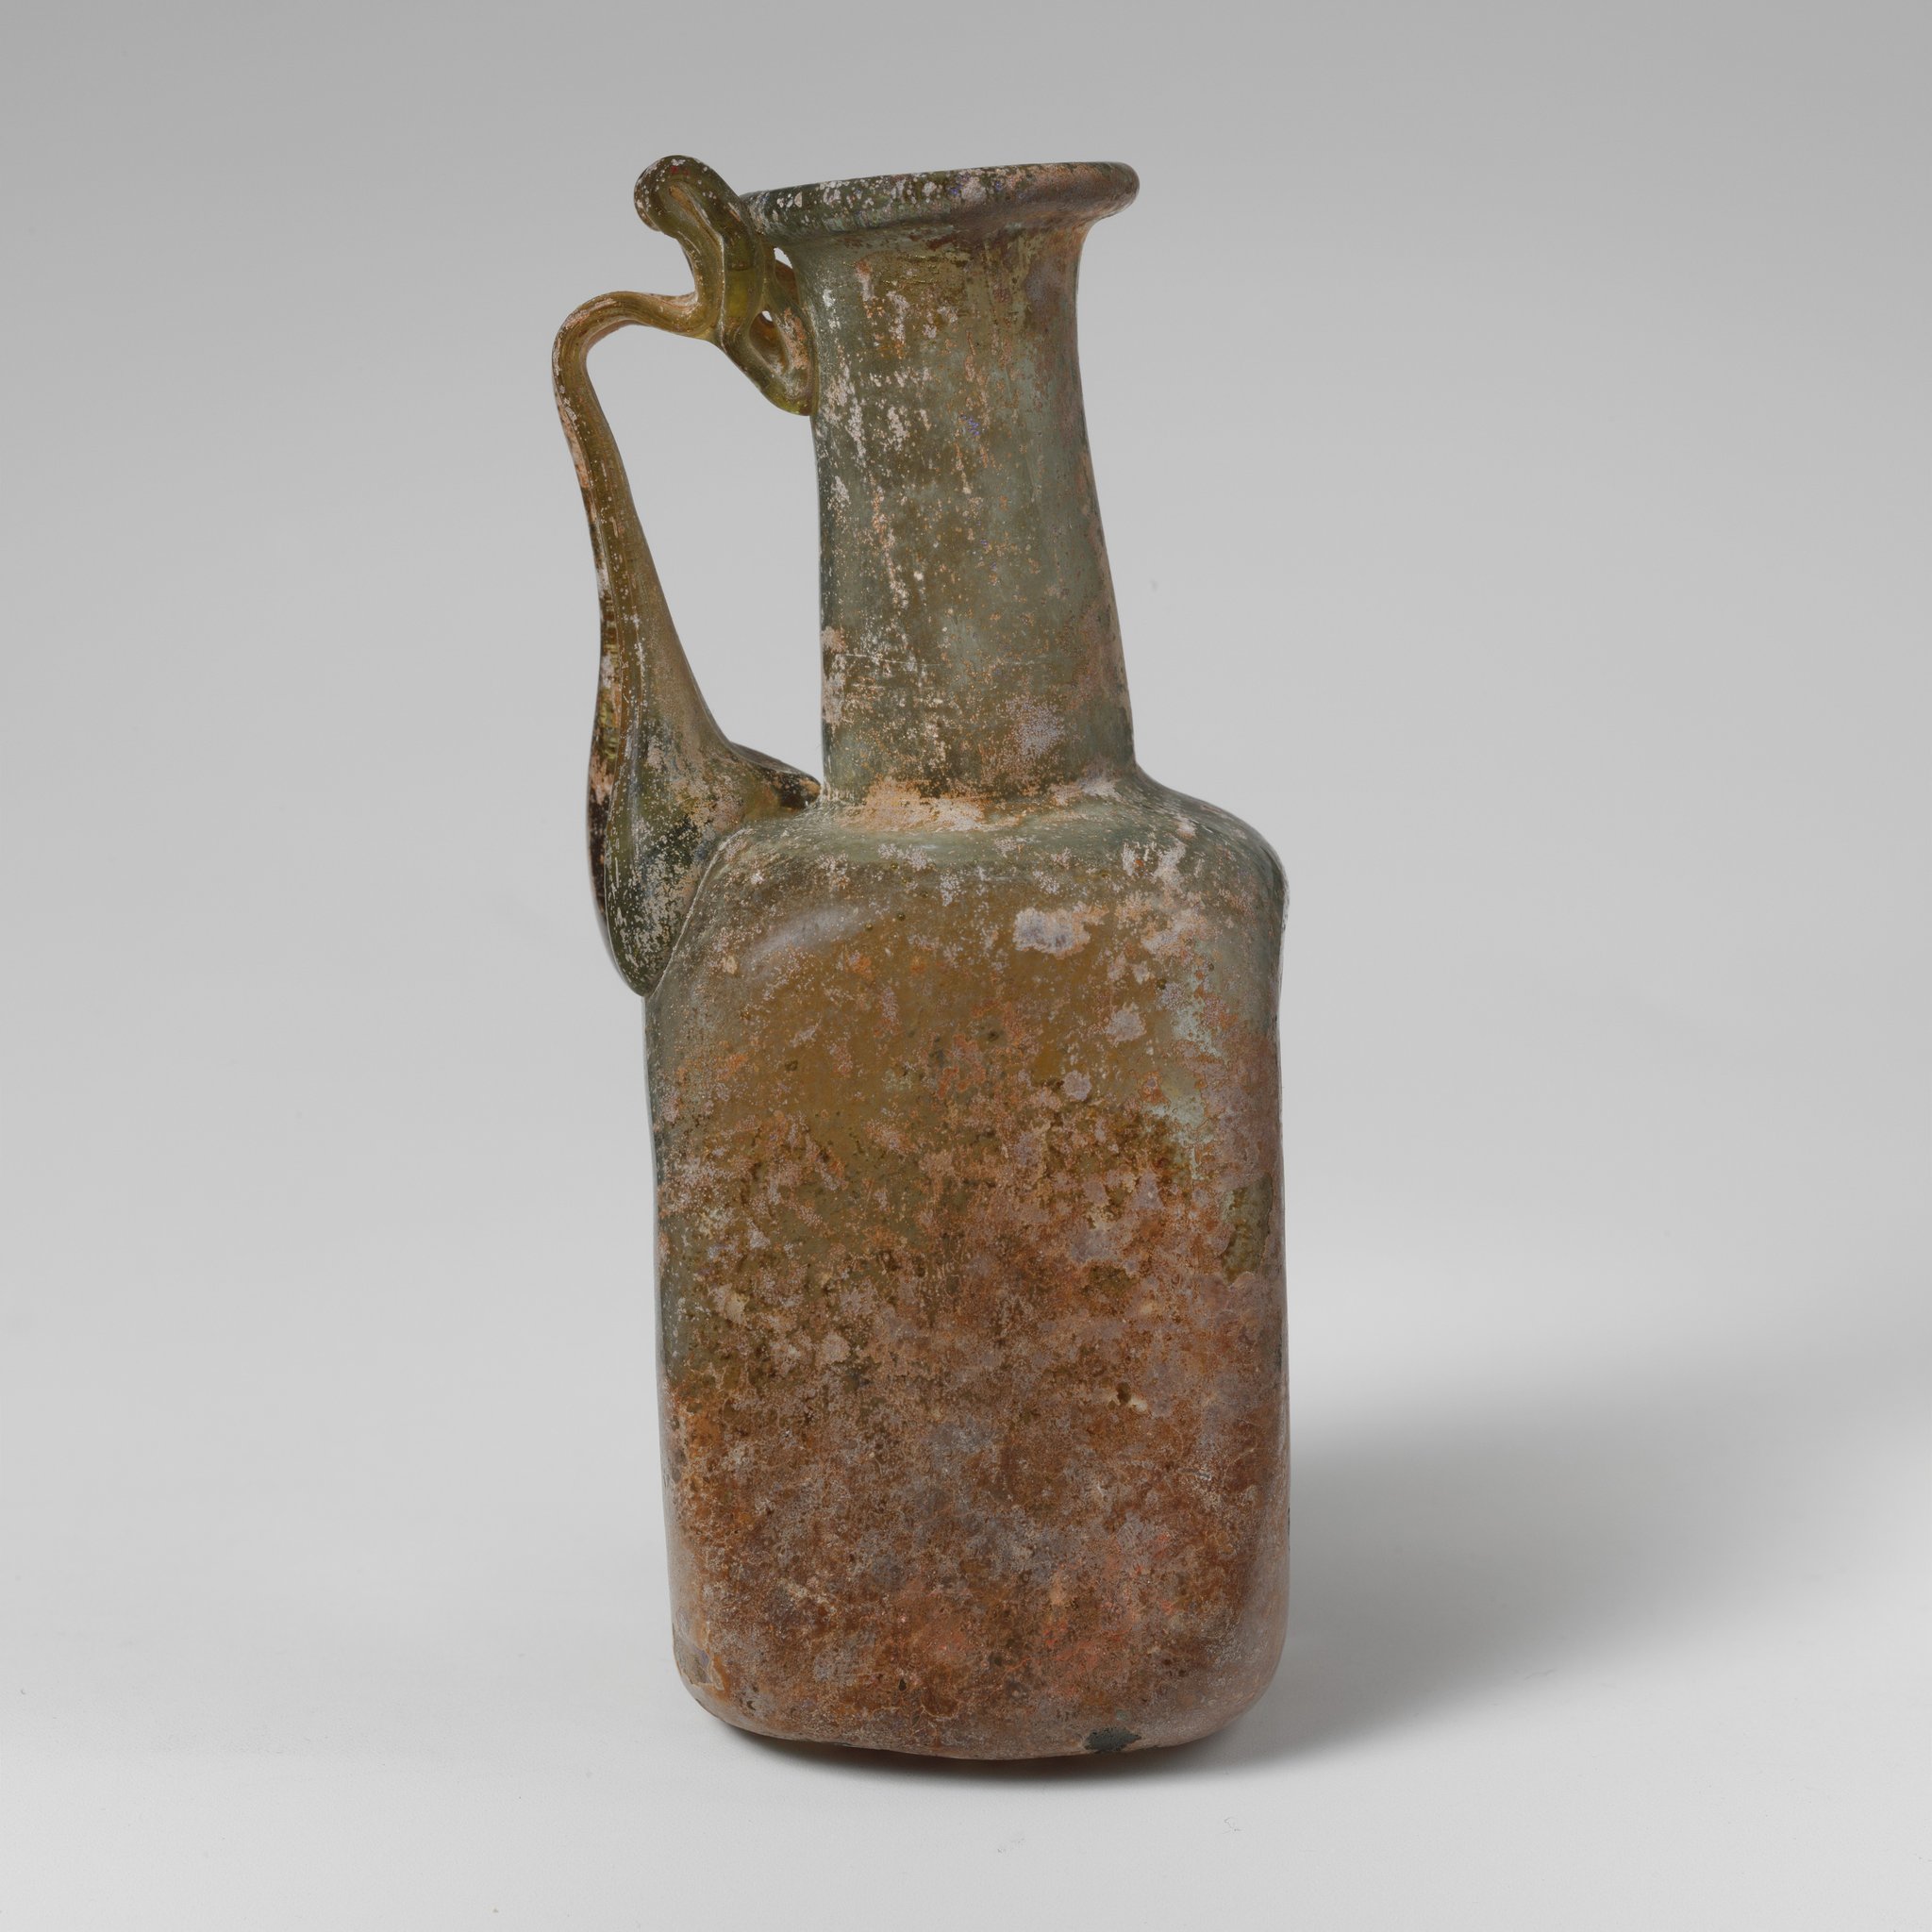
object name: bottle, square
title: Glass square bottle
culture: roman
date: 101-300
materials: glass